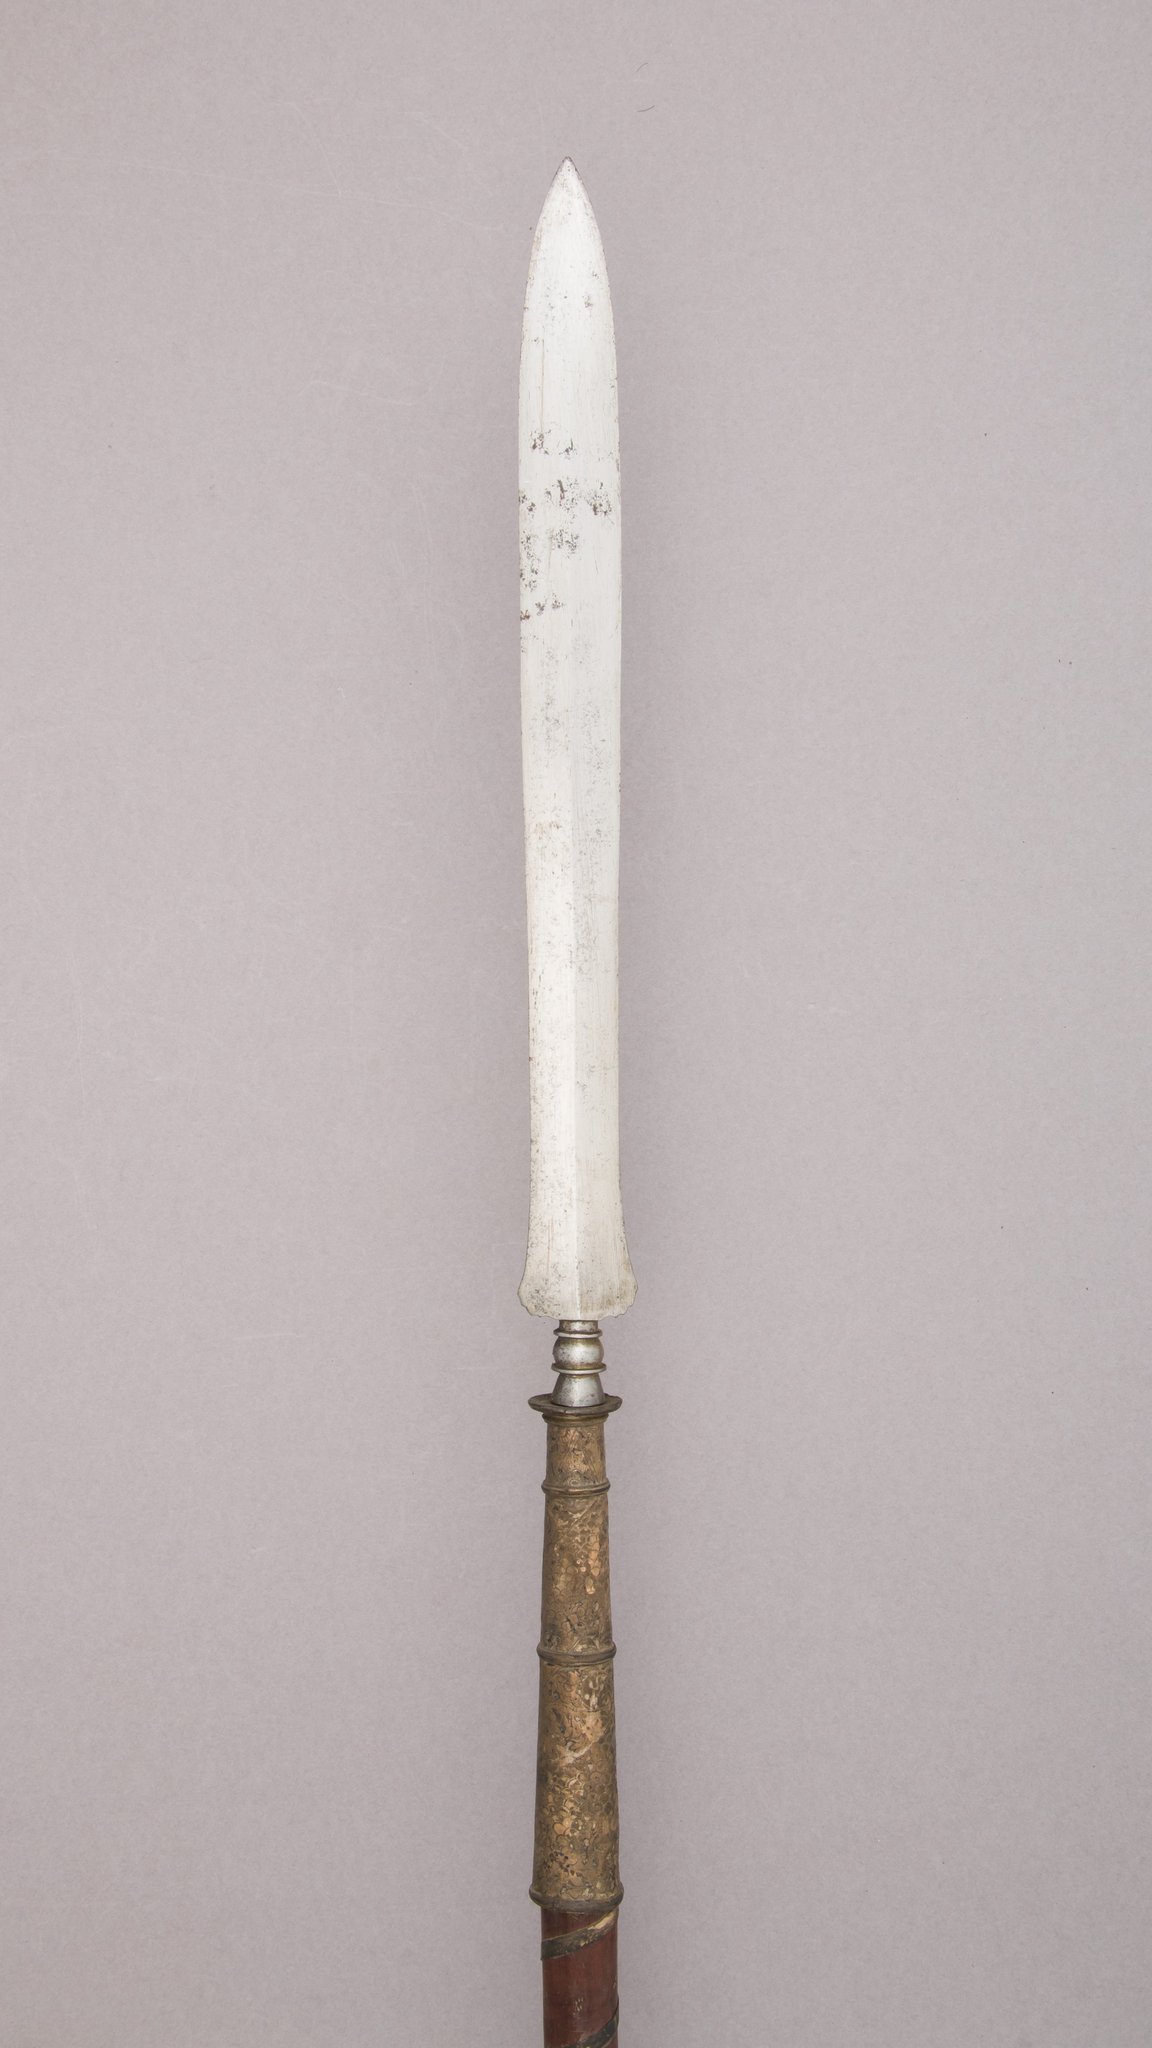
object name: spear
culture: javanese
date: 1501-1900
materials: silver, steel, wood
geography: indonesia